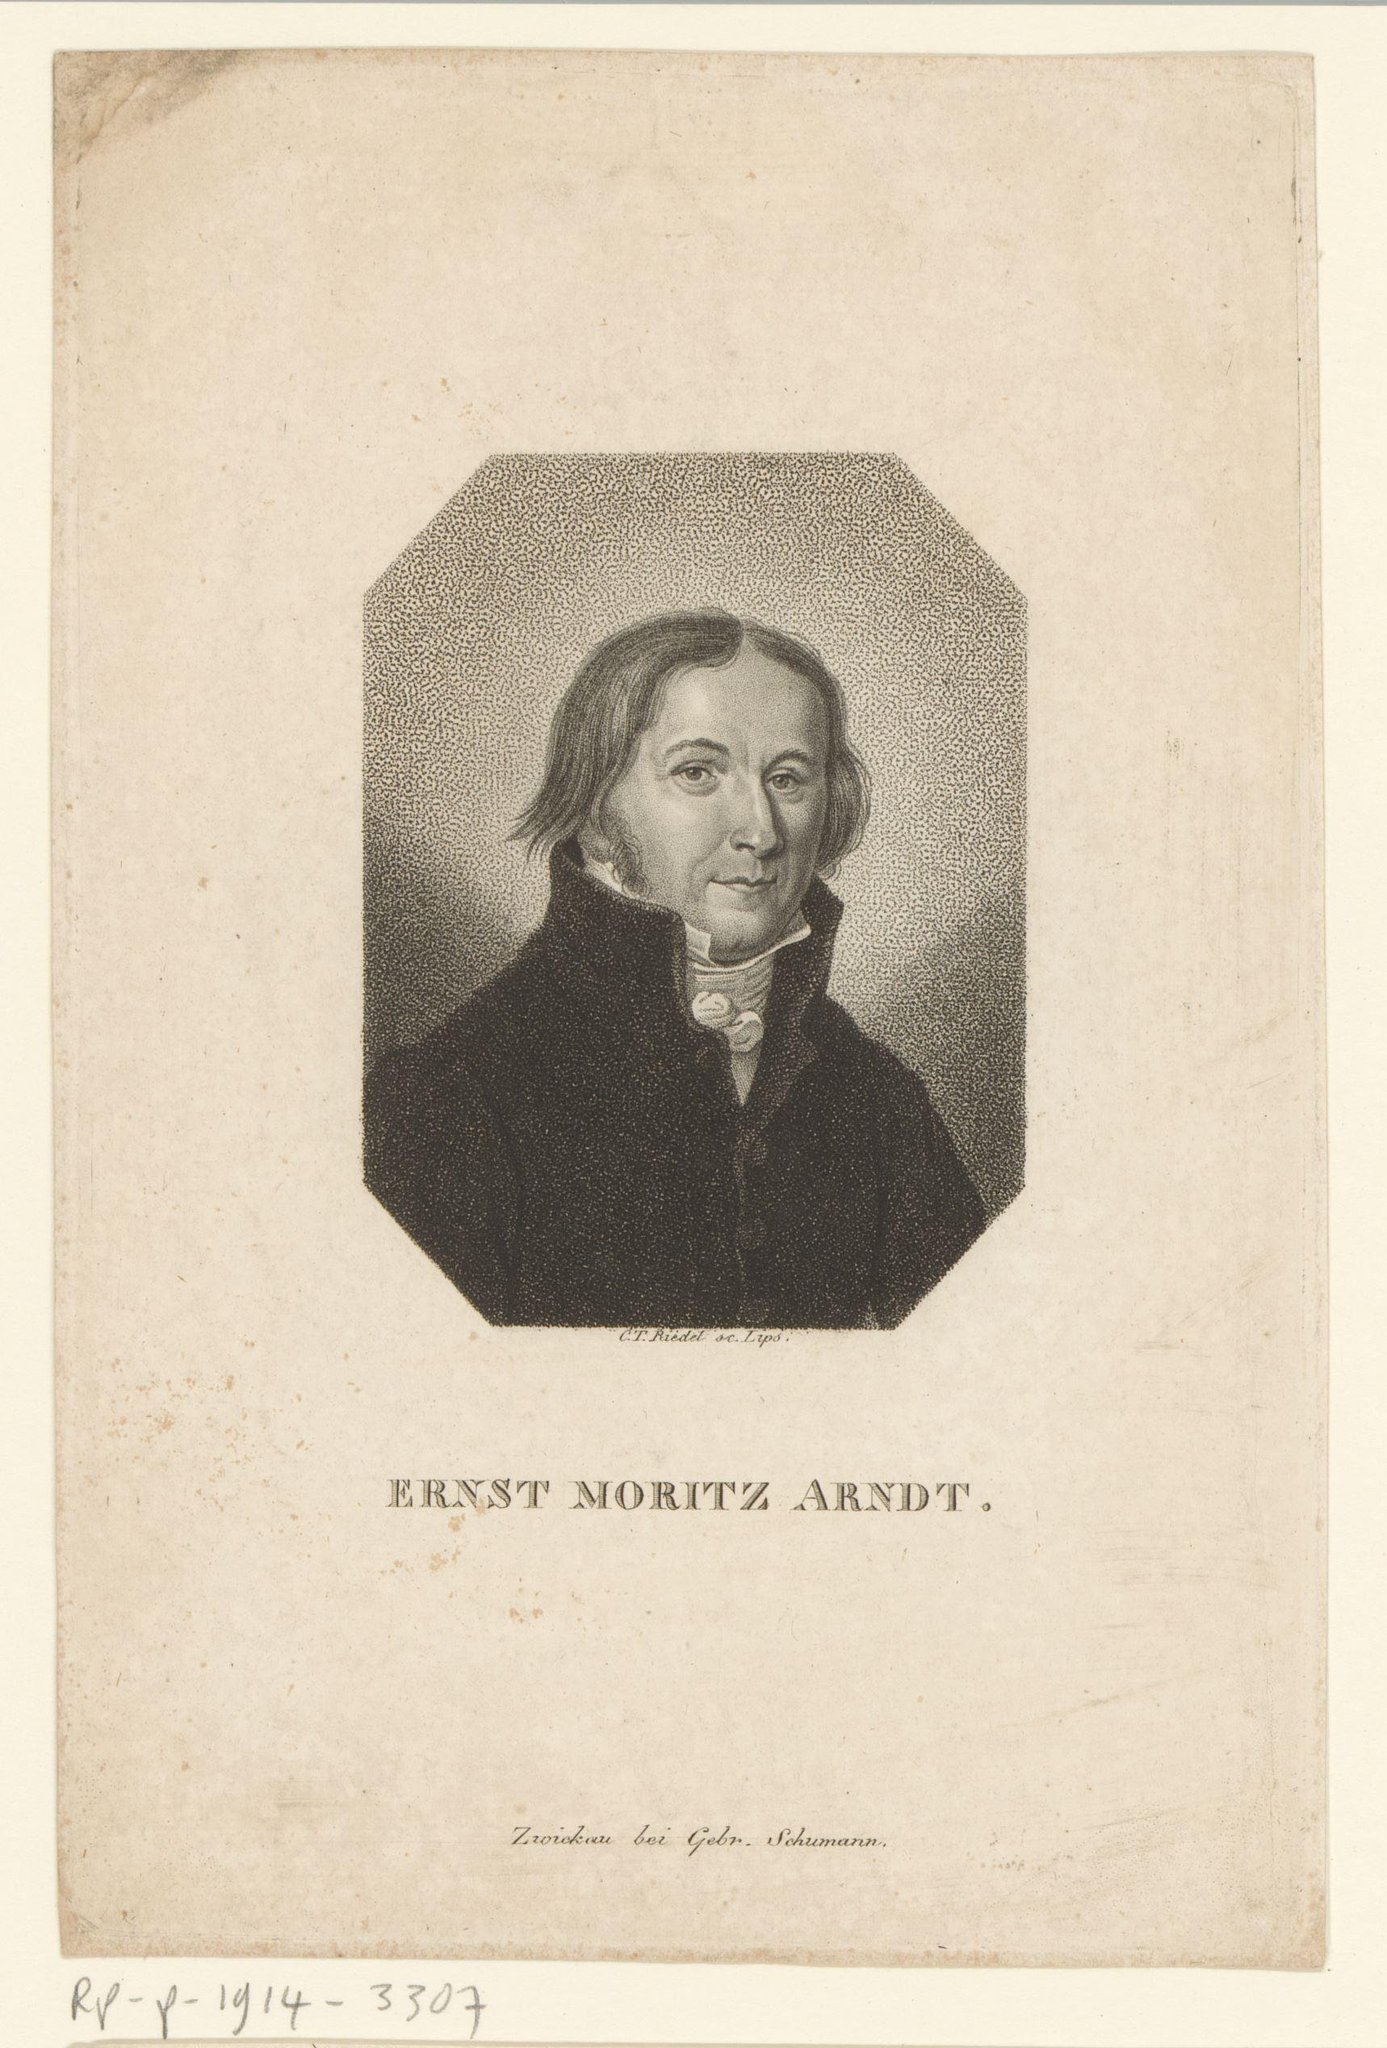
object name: print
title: Portret van Ernst Moritz Arndt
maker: karl traugott riedel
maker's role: print maker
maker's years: 1769-1832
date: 1779-1850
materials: paper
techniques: engraving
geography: leipzig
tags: historical persons, portrait of a writer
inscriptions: collector's mark: Lugt 2228